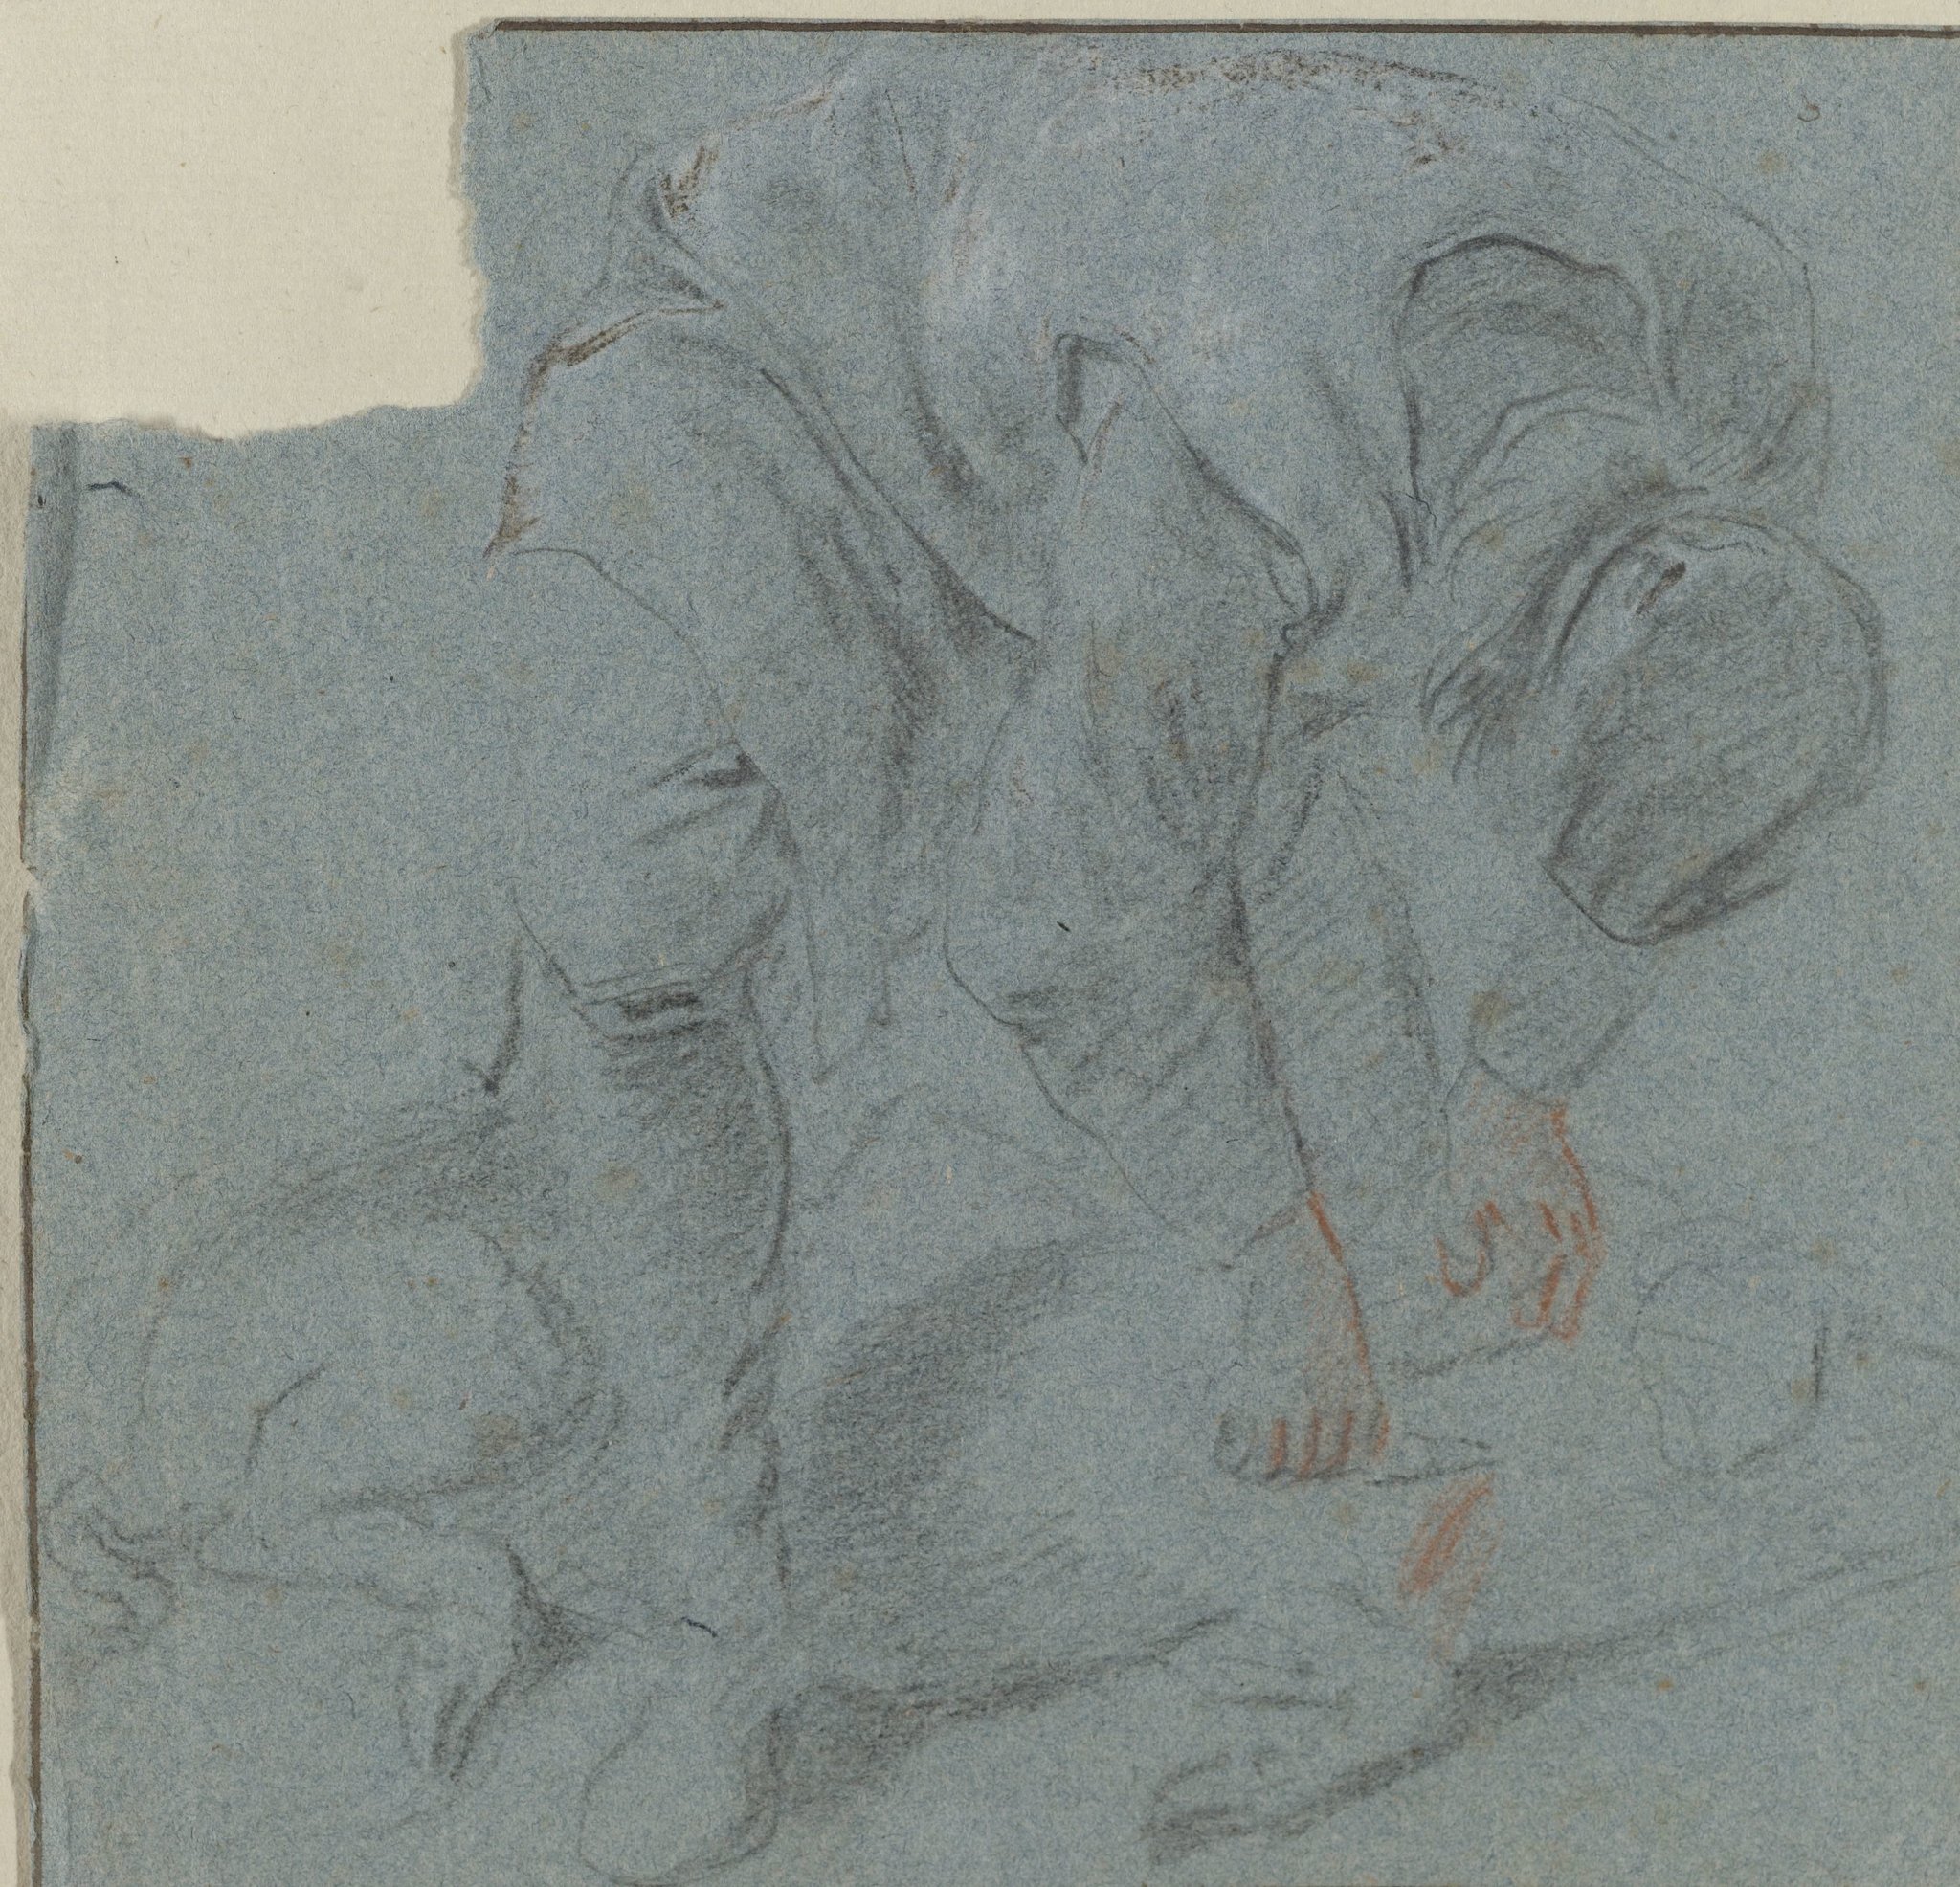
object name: drawing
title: Voorovergebogen man doodt een varken met een mes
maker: cornelis dusart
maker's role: draughtsman, painter, print maker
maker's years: 1660-1704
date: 1670-1704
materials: chalk, paper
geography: netherlands